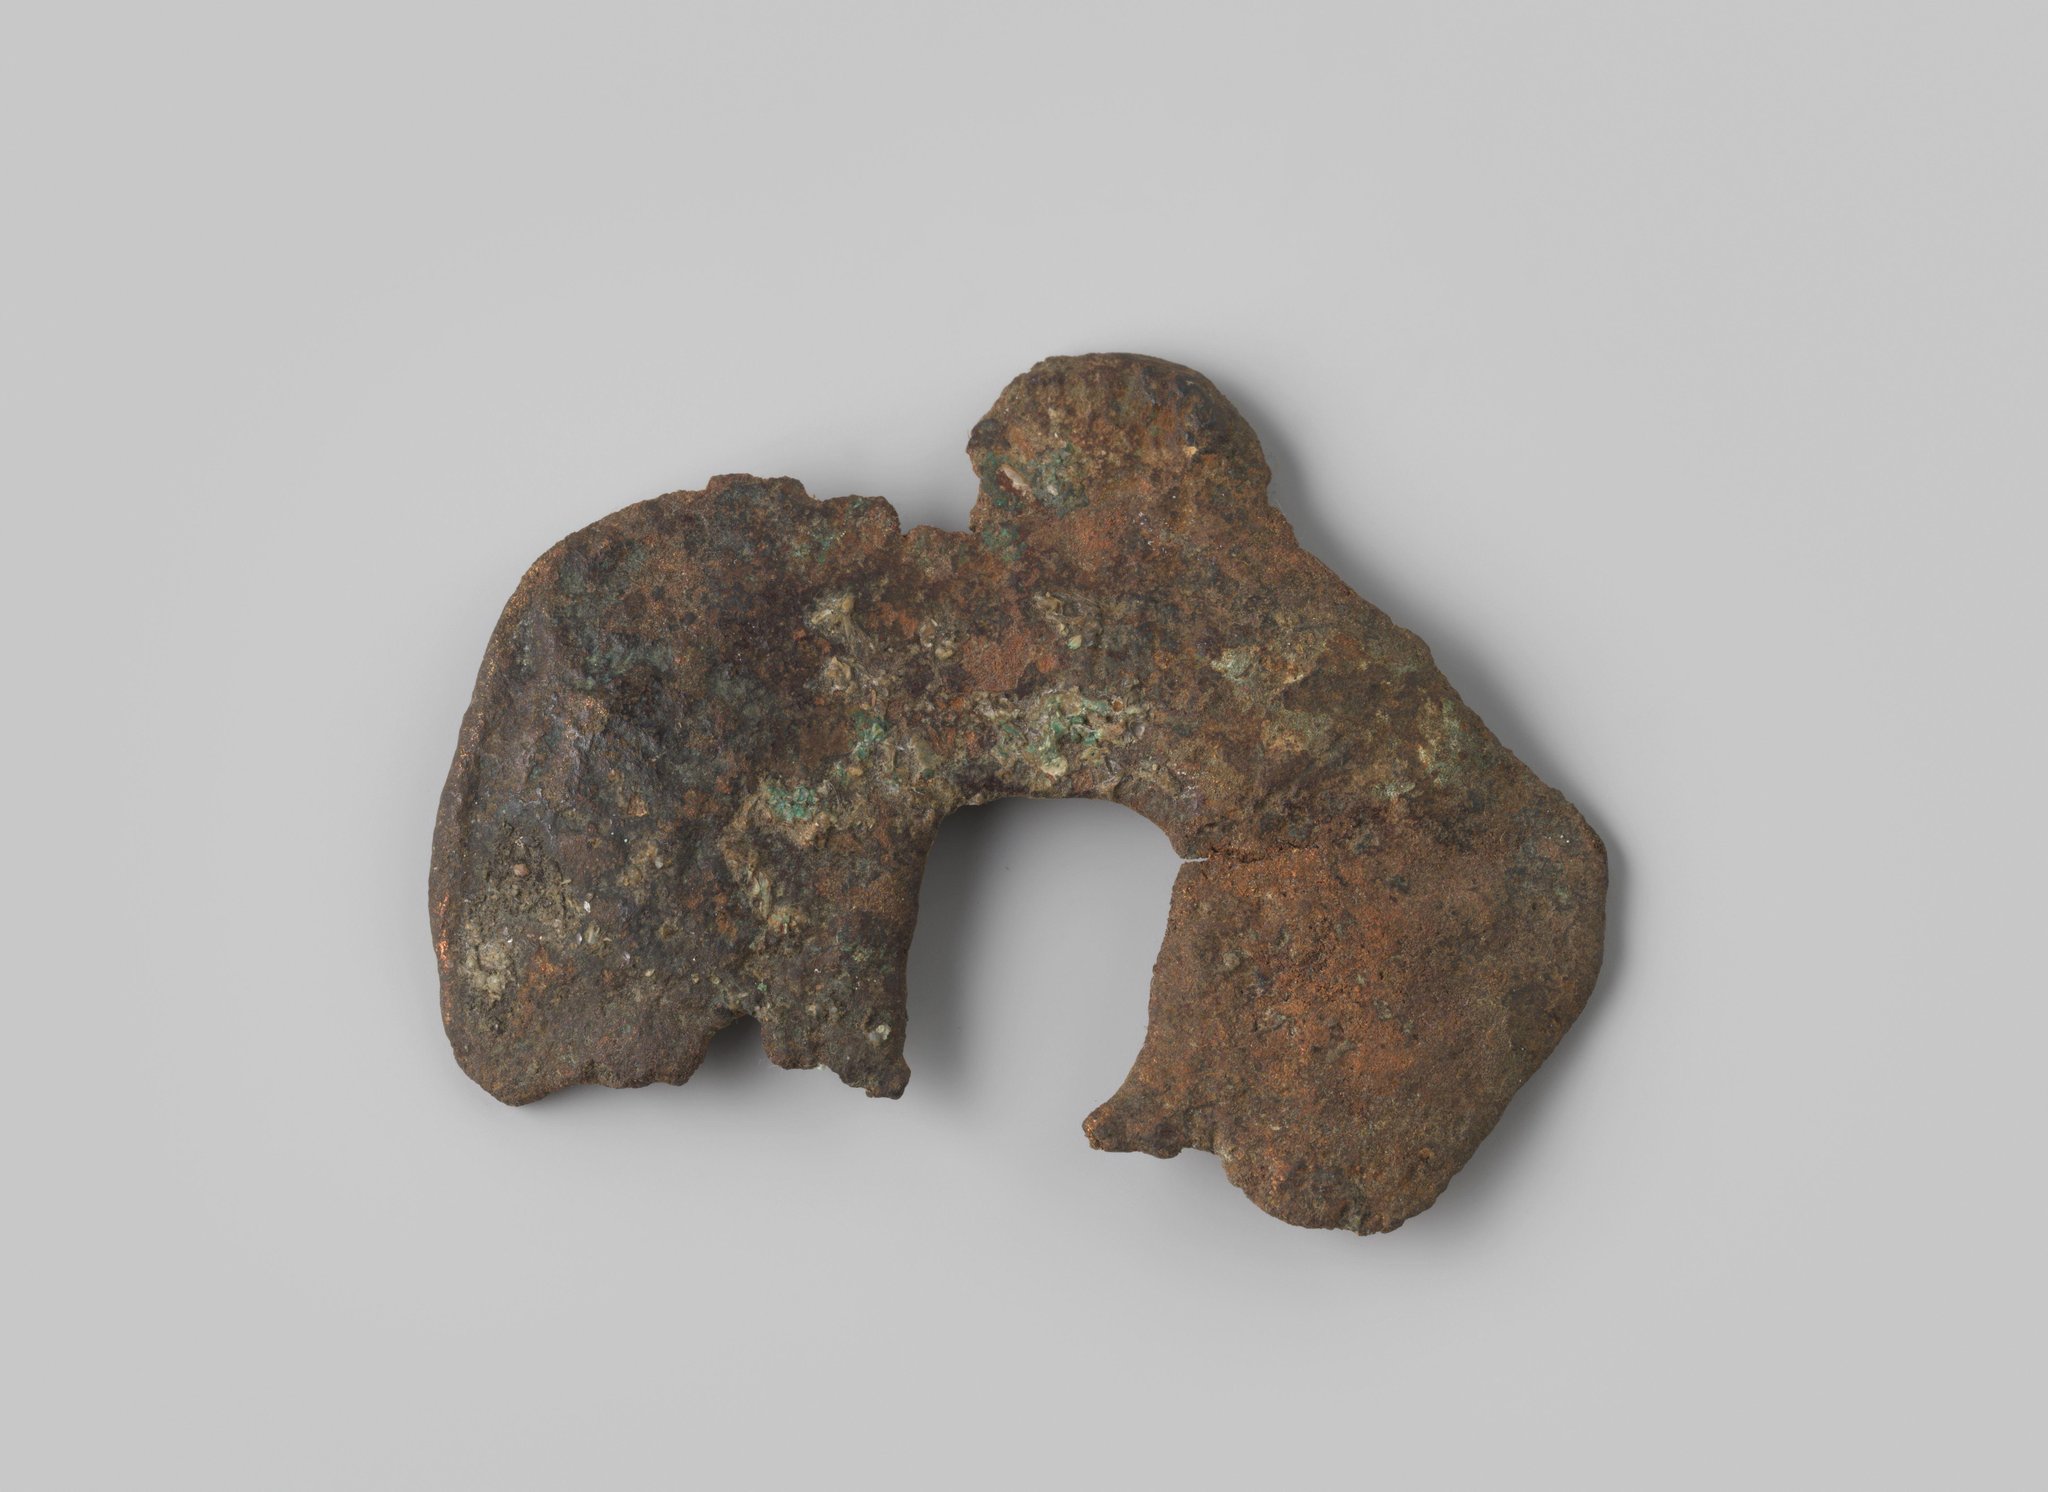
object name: beugel gevestl, gevestbeugel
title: Fragment beugel van gevest uit het wrak van de Oost-Indiëvaarder Hollandia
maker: Anonymous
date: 1700-1743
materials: copper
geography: netherlands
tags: verenigde oostindische compagnie, hollandia (schip), annet